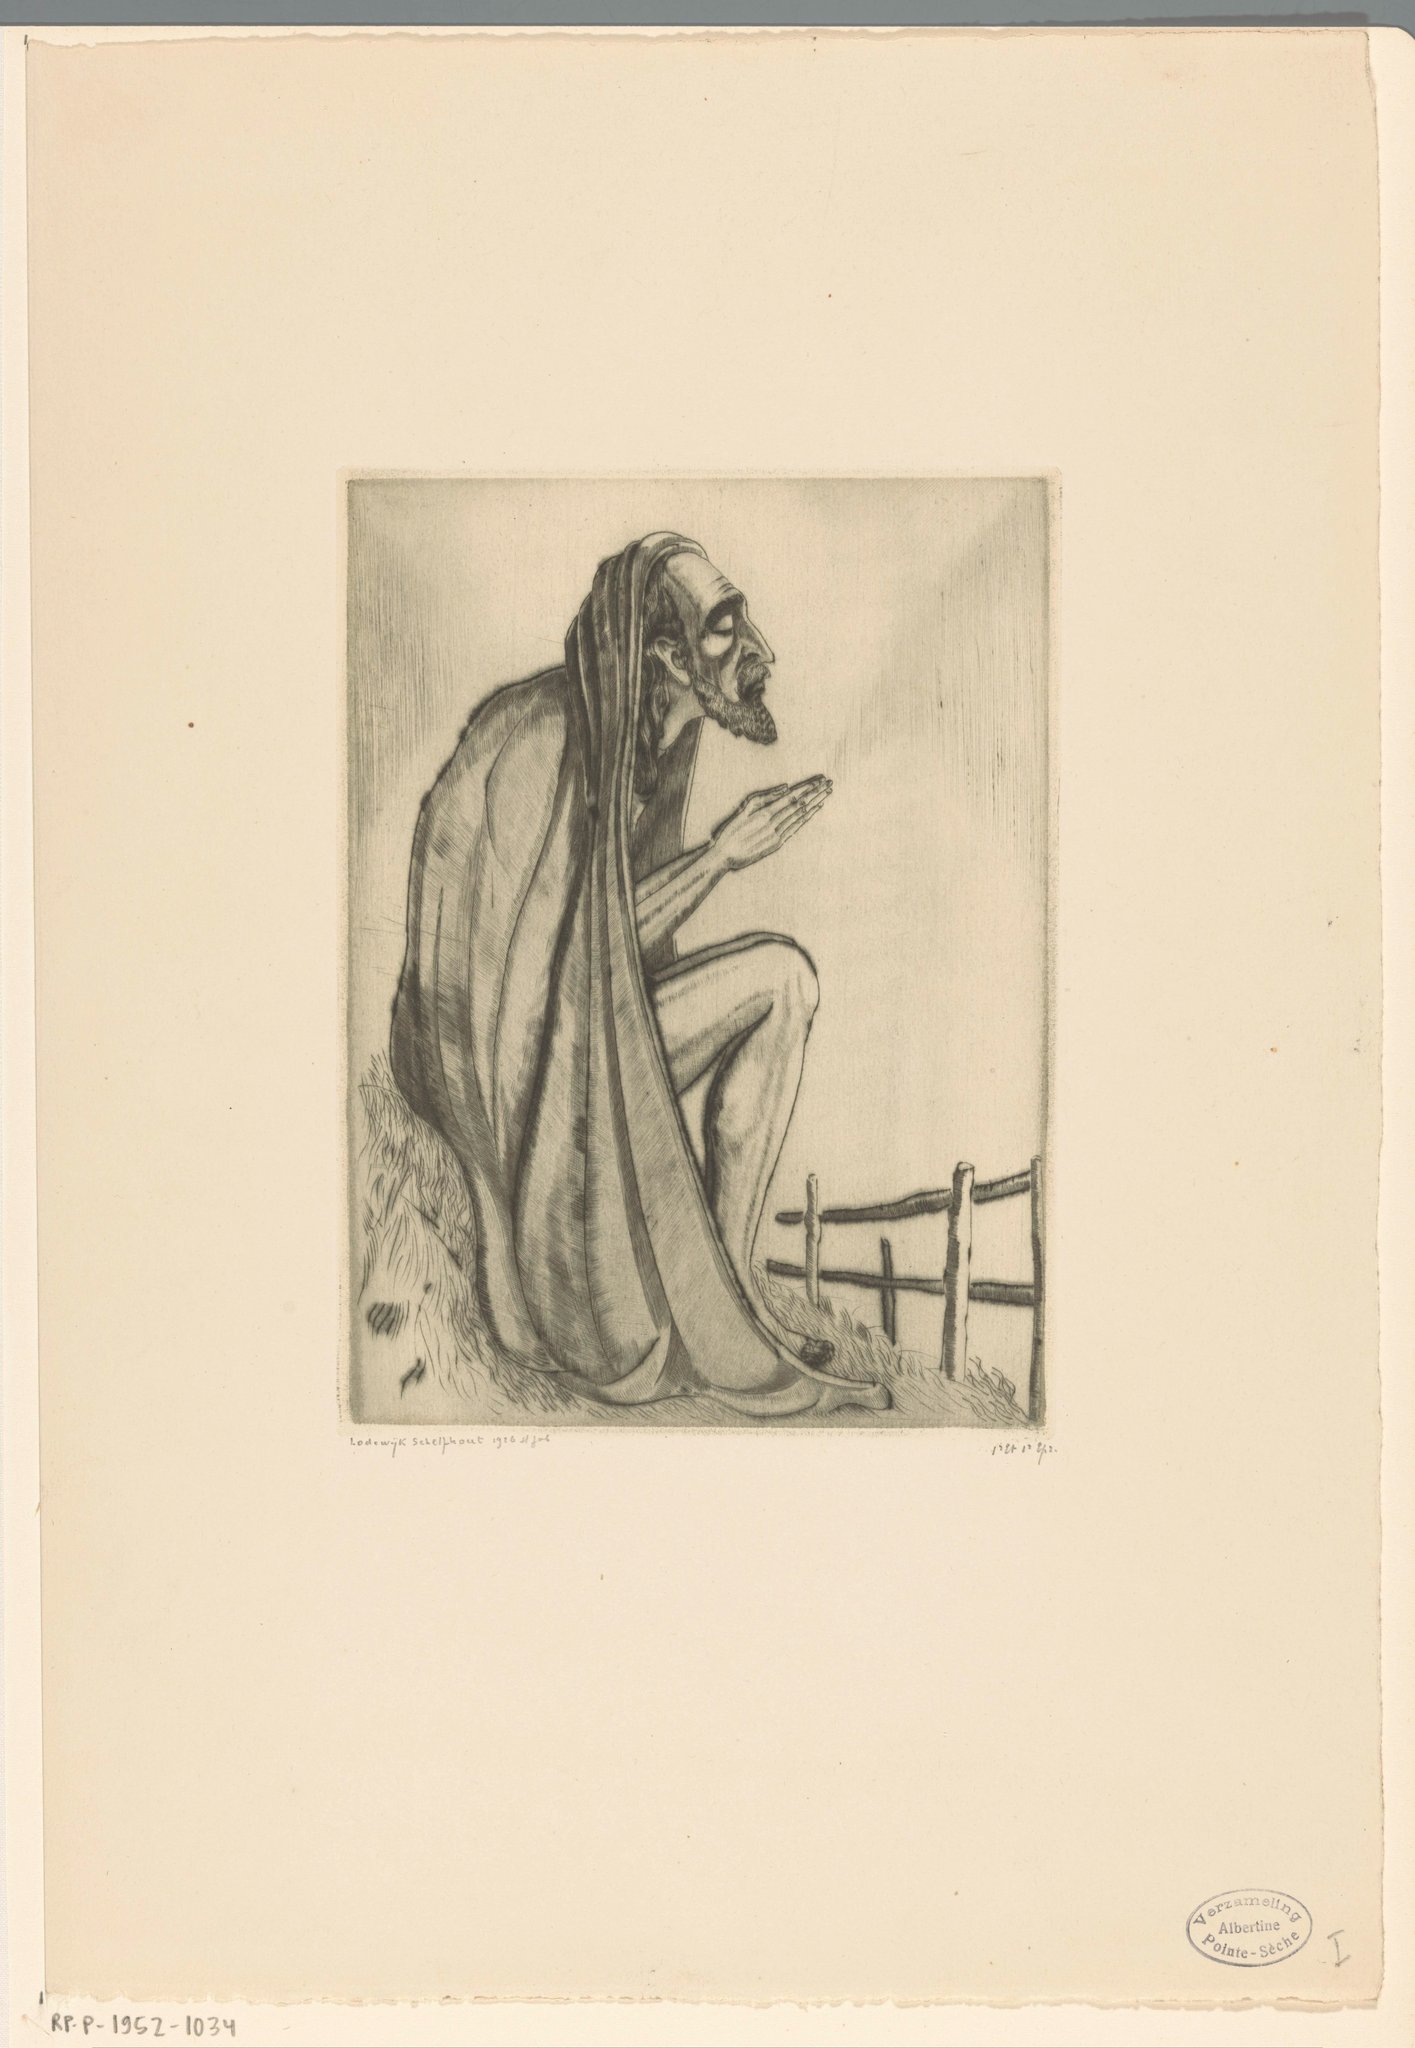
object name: print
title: Job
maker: lodewijk schelfhout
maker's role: draughtsman, print maker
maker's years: 1881-1943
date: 1926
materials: paper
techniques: drypoint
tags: (public) prayer, the book of job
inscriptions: collector's mark: Lugt 2760, collector's mark: Lugt 5i, collector's mark: Lugt 2228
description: Job, met samengevouwen handen en gesloten ogen, zittend bij een hek.